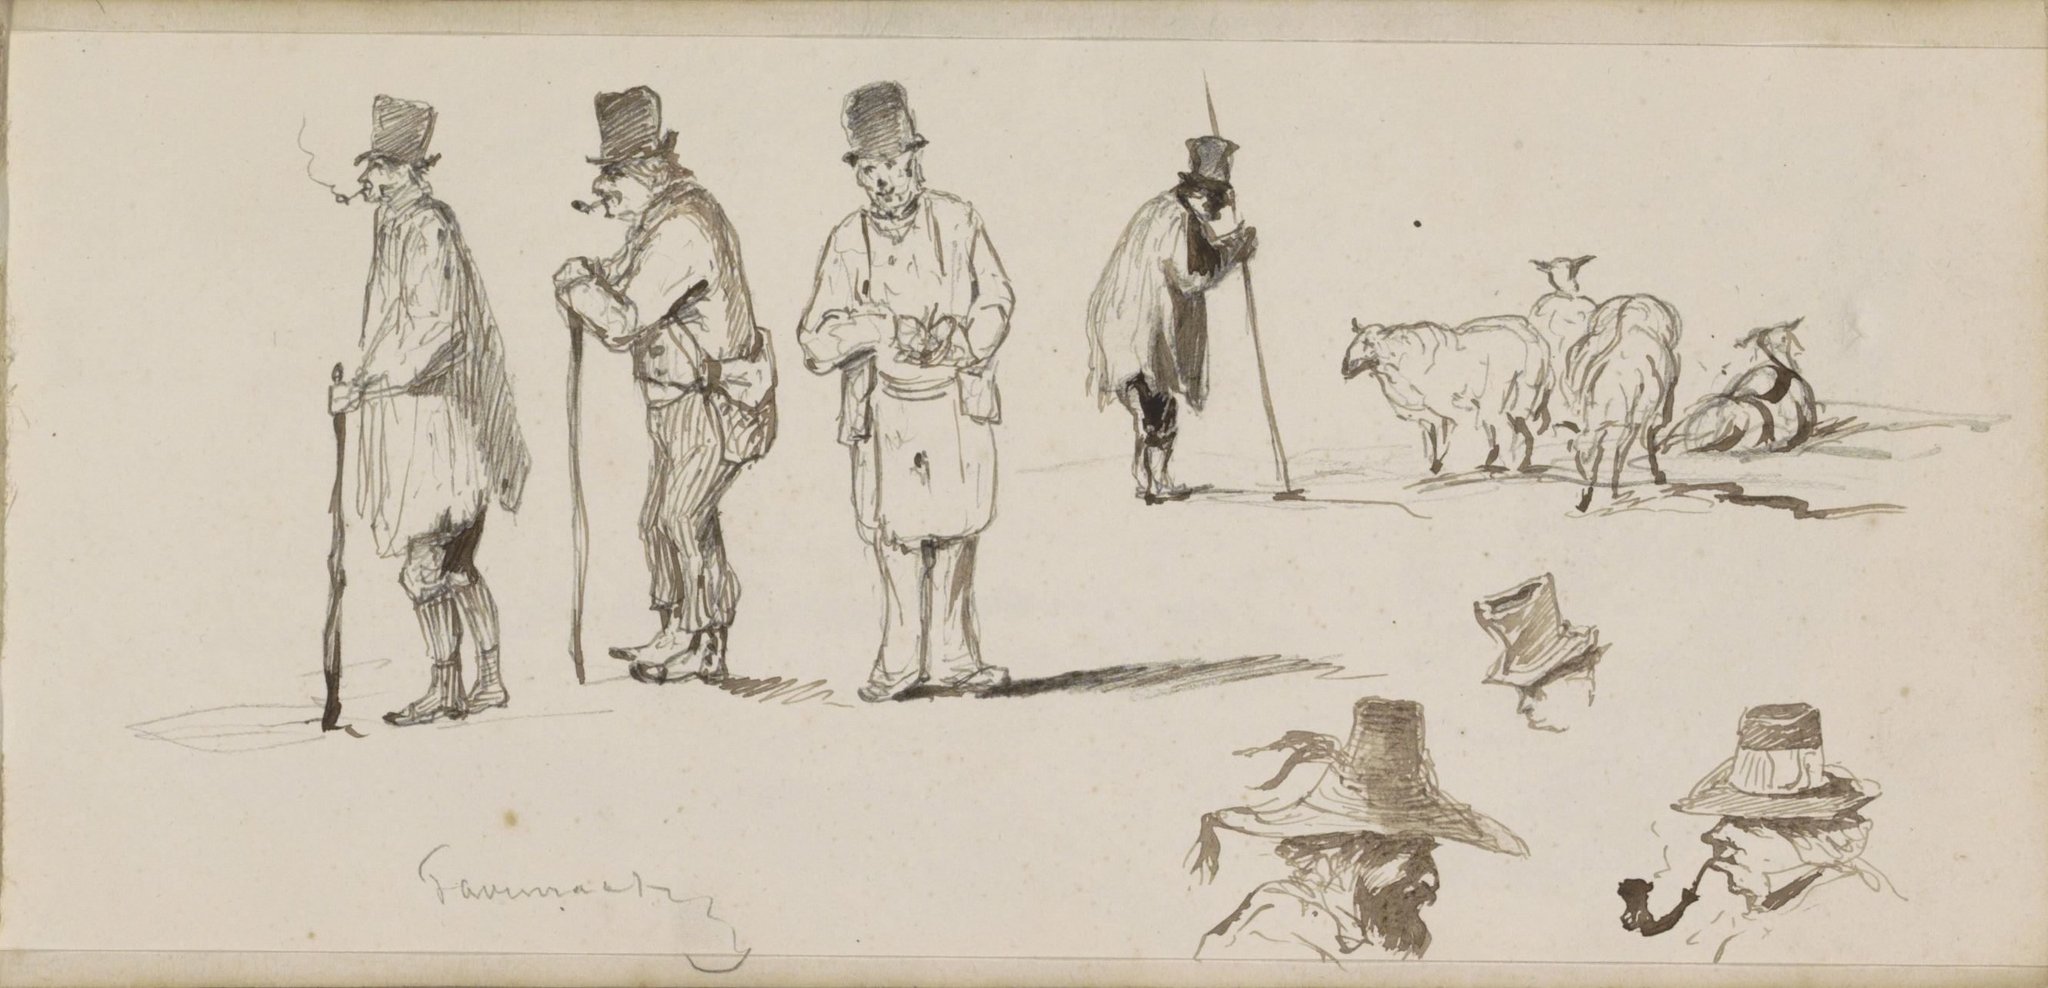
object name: sketchbook leaf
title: Mannen met hoge hoeden en wandelstokken, mannenkoppen en een schapenherder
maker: johannes tavenraat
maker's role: draughtsman, painter, print maker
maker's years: 1809-1881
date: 1840-1868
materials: ink, paper, pencil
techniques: pen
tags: head (human), herding, herdsman, herdswoman, shepherd, shepherdess, cowherd, etc., walking-stick, staff, adult man, sheep, head-gear: top hat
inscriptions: signature: ‘Tavenraat’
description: Blad 17 recto uit een schetsboek met 63 bladen.